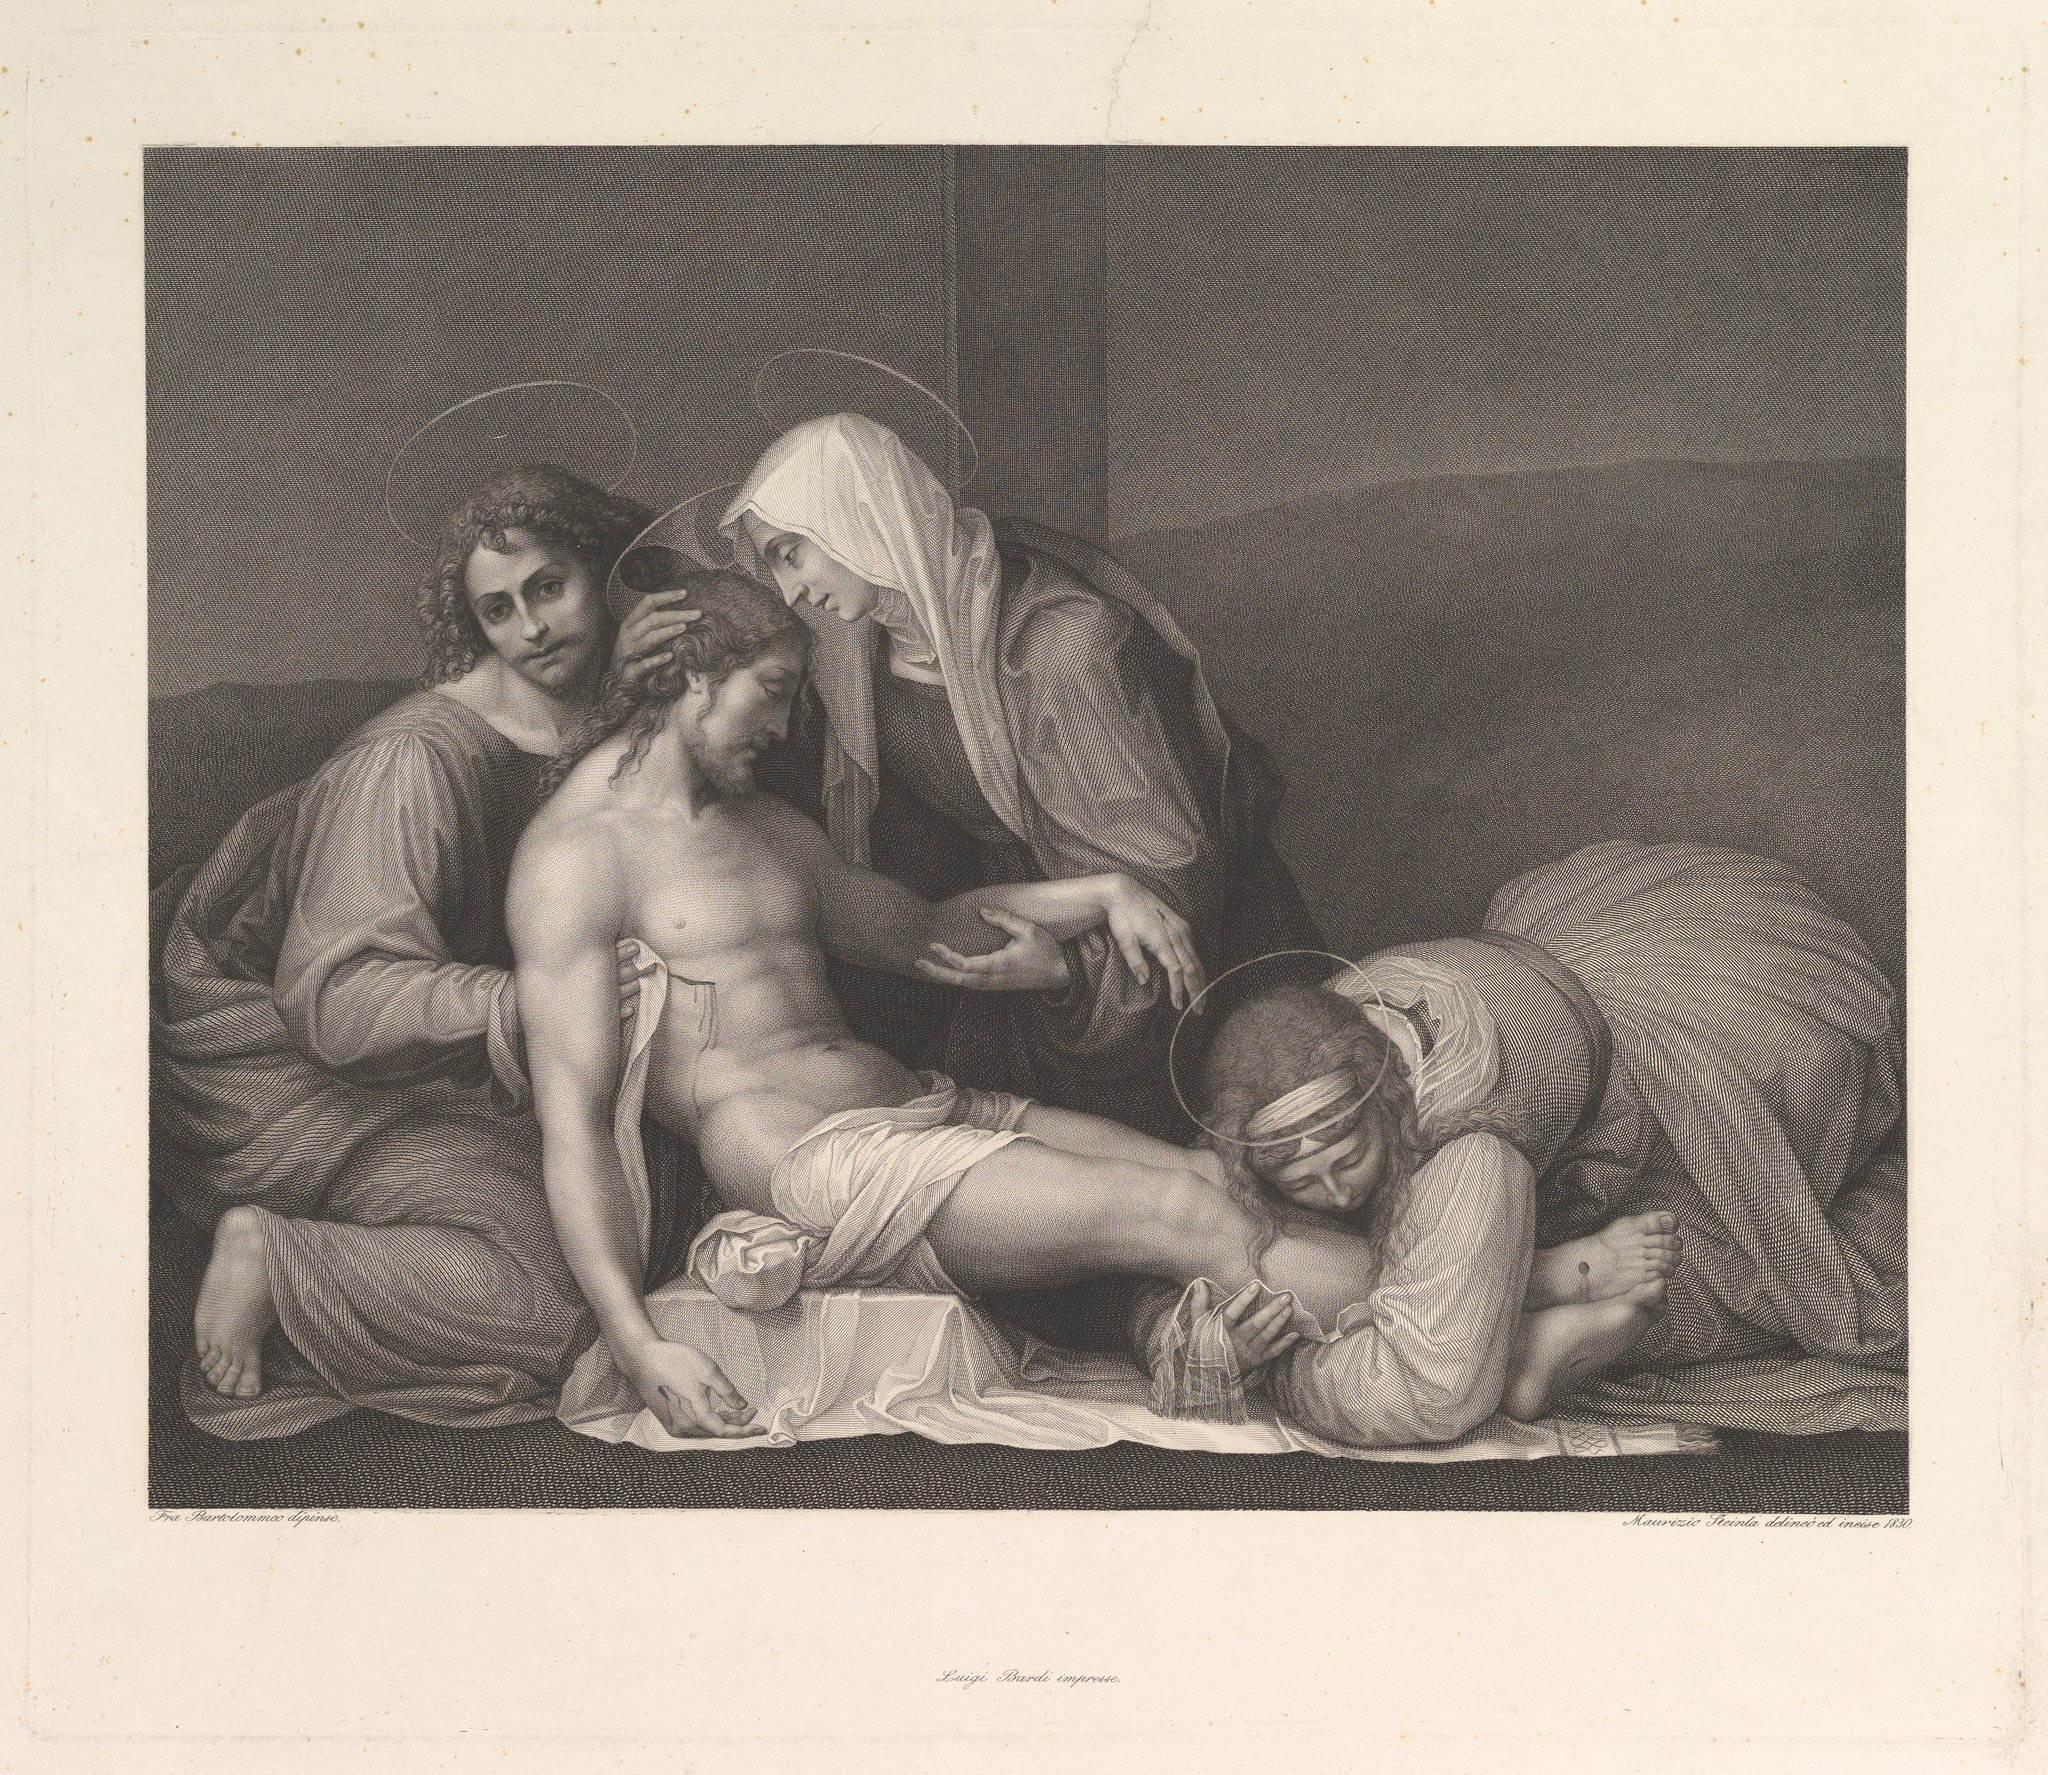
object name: print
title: The Lamentation of Christ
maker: franz anton erich moritz steinla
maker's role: artist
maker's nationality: german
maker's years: 1791-1858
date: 1841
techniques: engraving, etching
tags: christ,lamentation